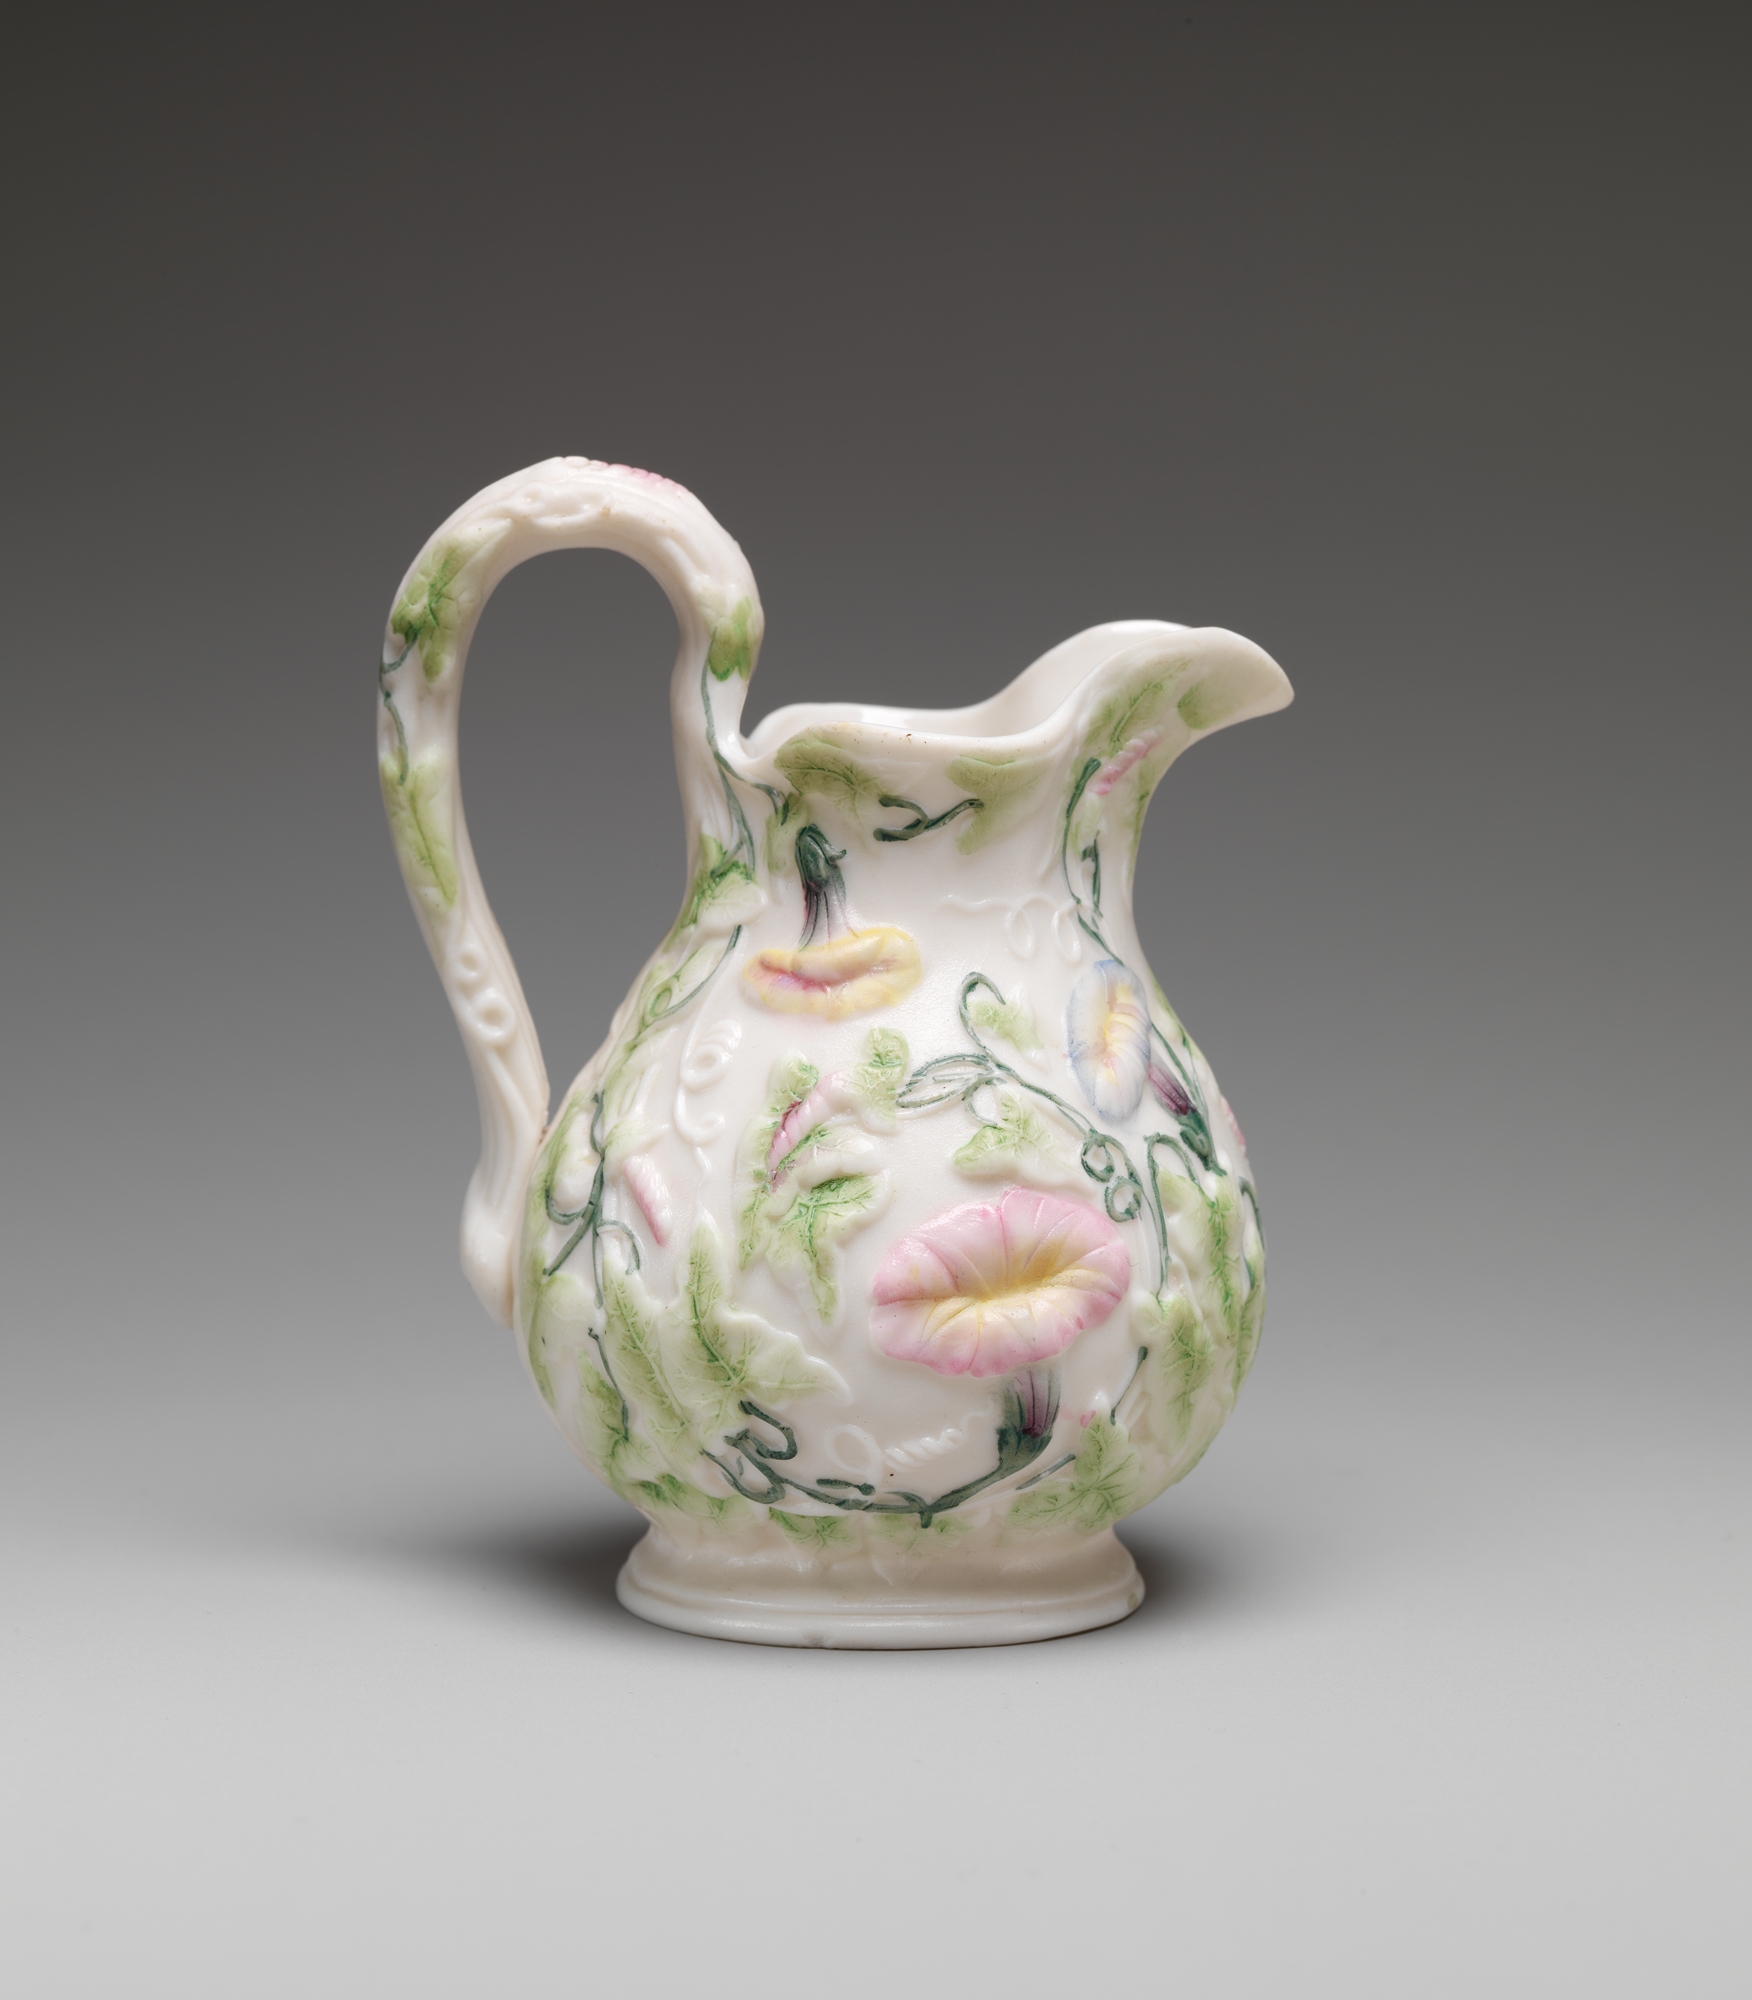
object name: pitcher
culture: american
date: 1830-1870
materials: porcelain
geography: united states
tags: flowers